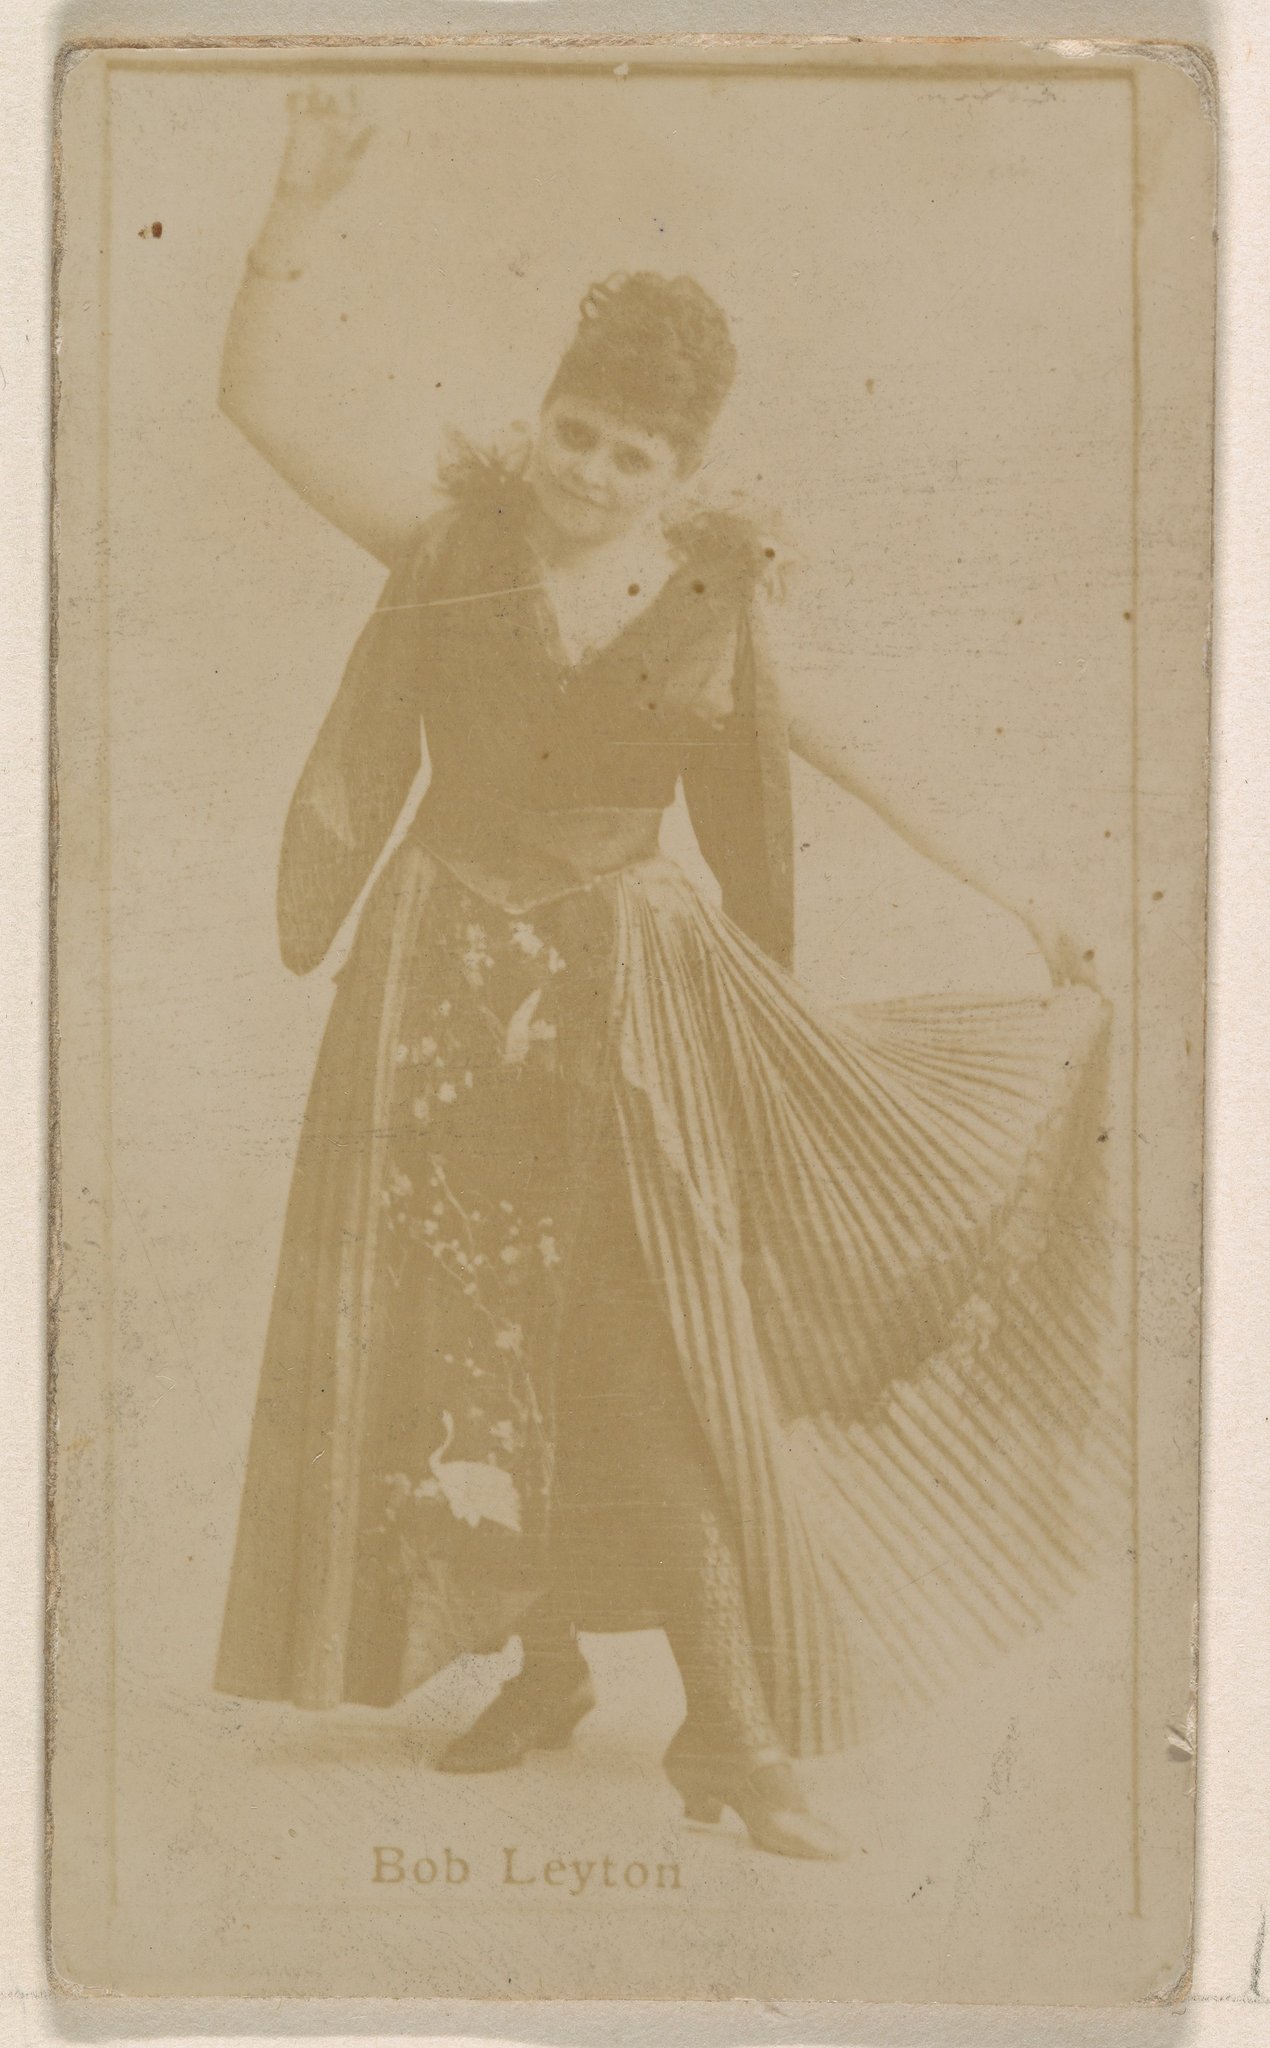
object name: photograph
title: Bob Leyton, from the Actresses series (N245) issued by Kinney Brothers to promote Sweet Caporal Cigarettes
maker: kinney brothers tobacco company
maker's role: publisher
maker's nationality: american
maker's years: 1869-2011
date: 1890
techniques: albumen silver print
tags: portraits,women,actresses